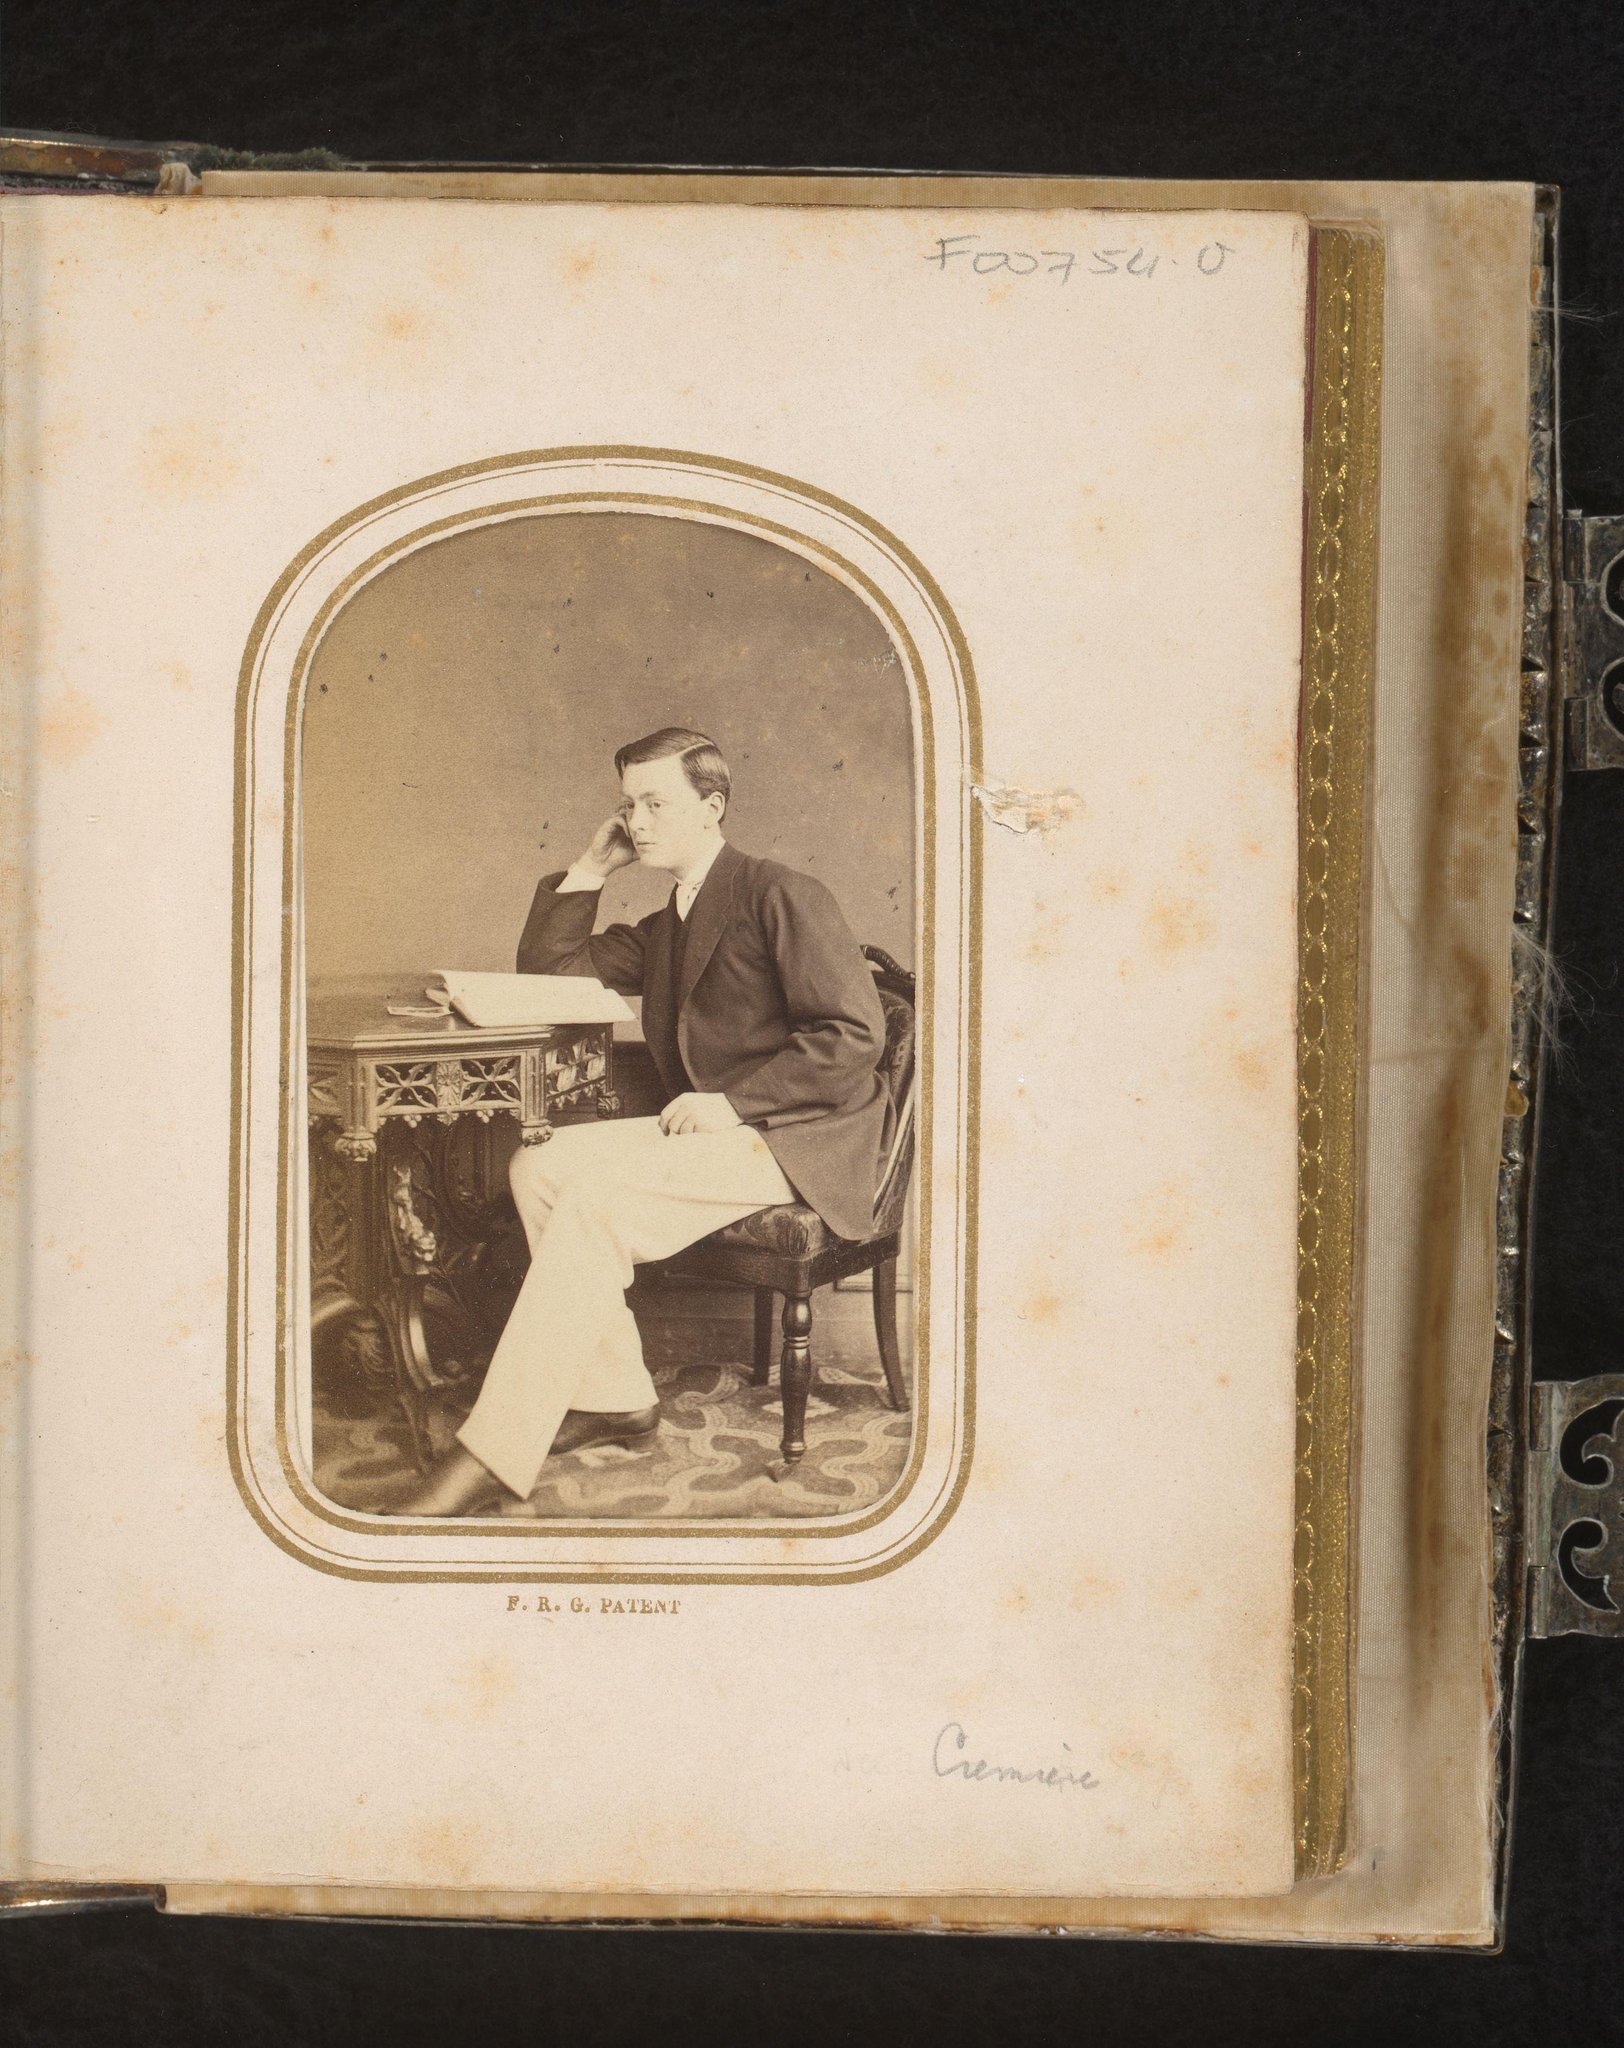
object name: carte de visite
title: Portret van een jongeman, zittend aan een tafel met boeken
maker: léon cremière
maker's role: fotograaf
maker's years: 1831-1913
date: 1855-1880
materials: cardboard, photographic support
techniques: albumen print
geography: paris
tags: youth, adolescent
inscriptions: inscription: ‘Paris, 28 Rue de Laval’